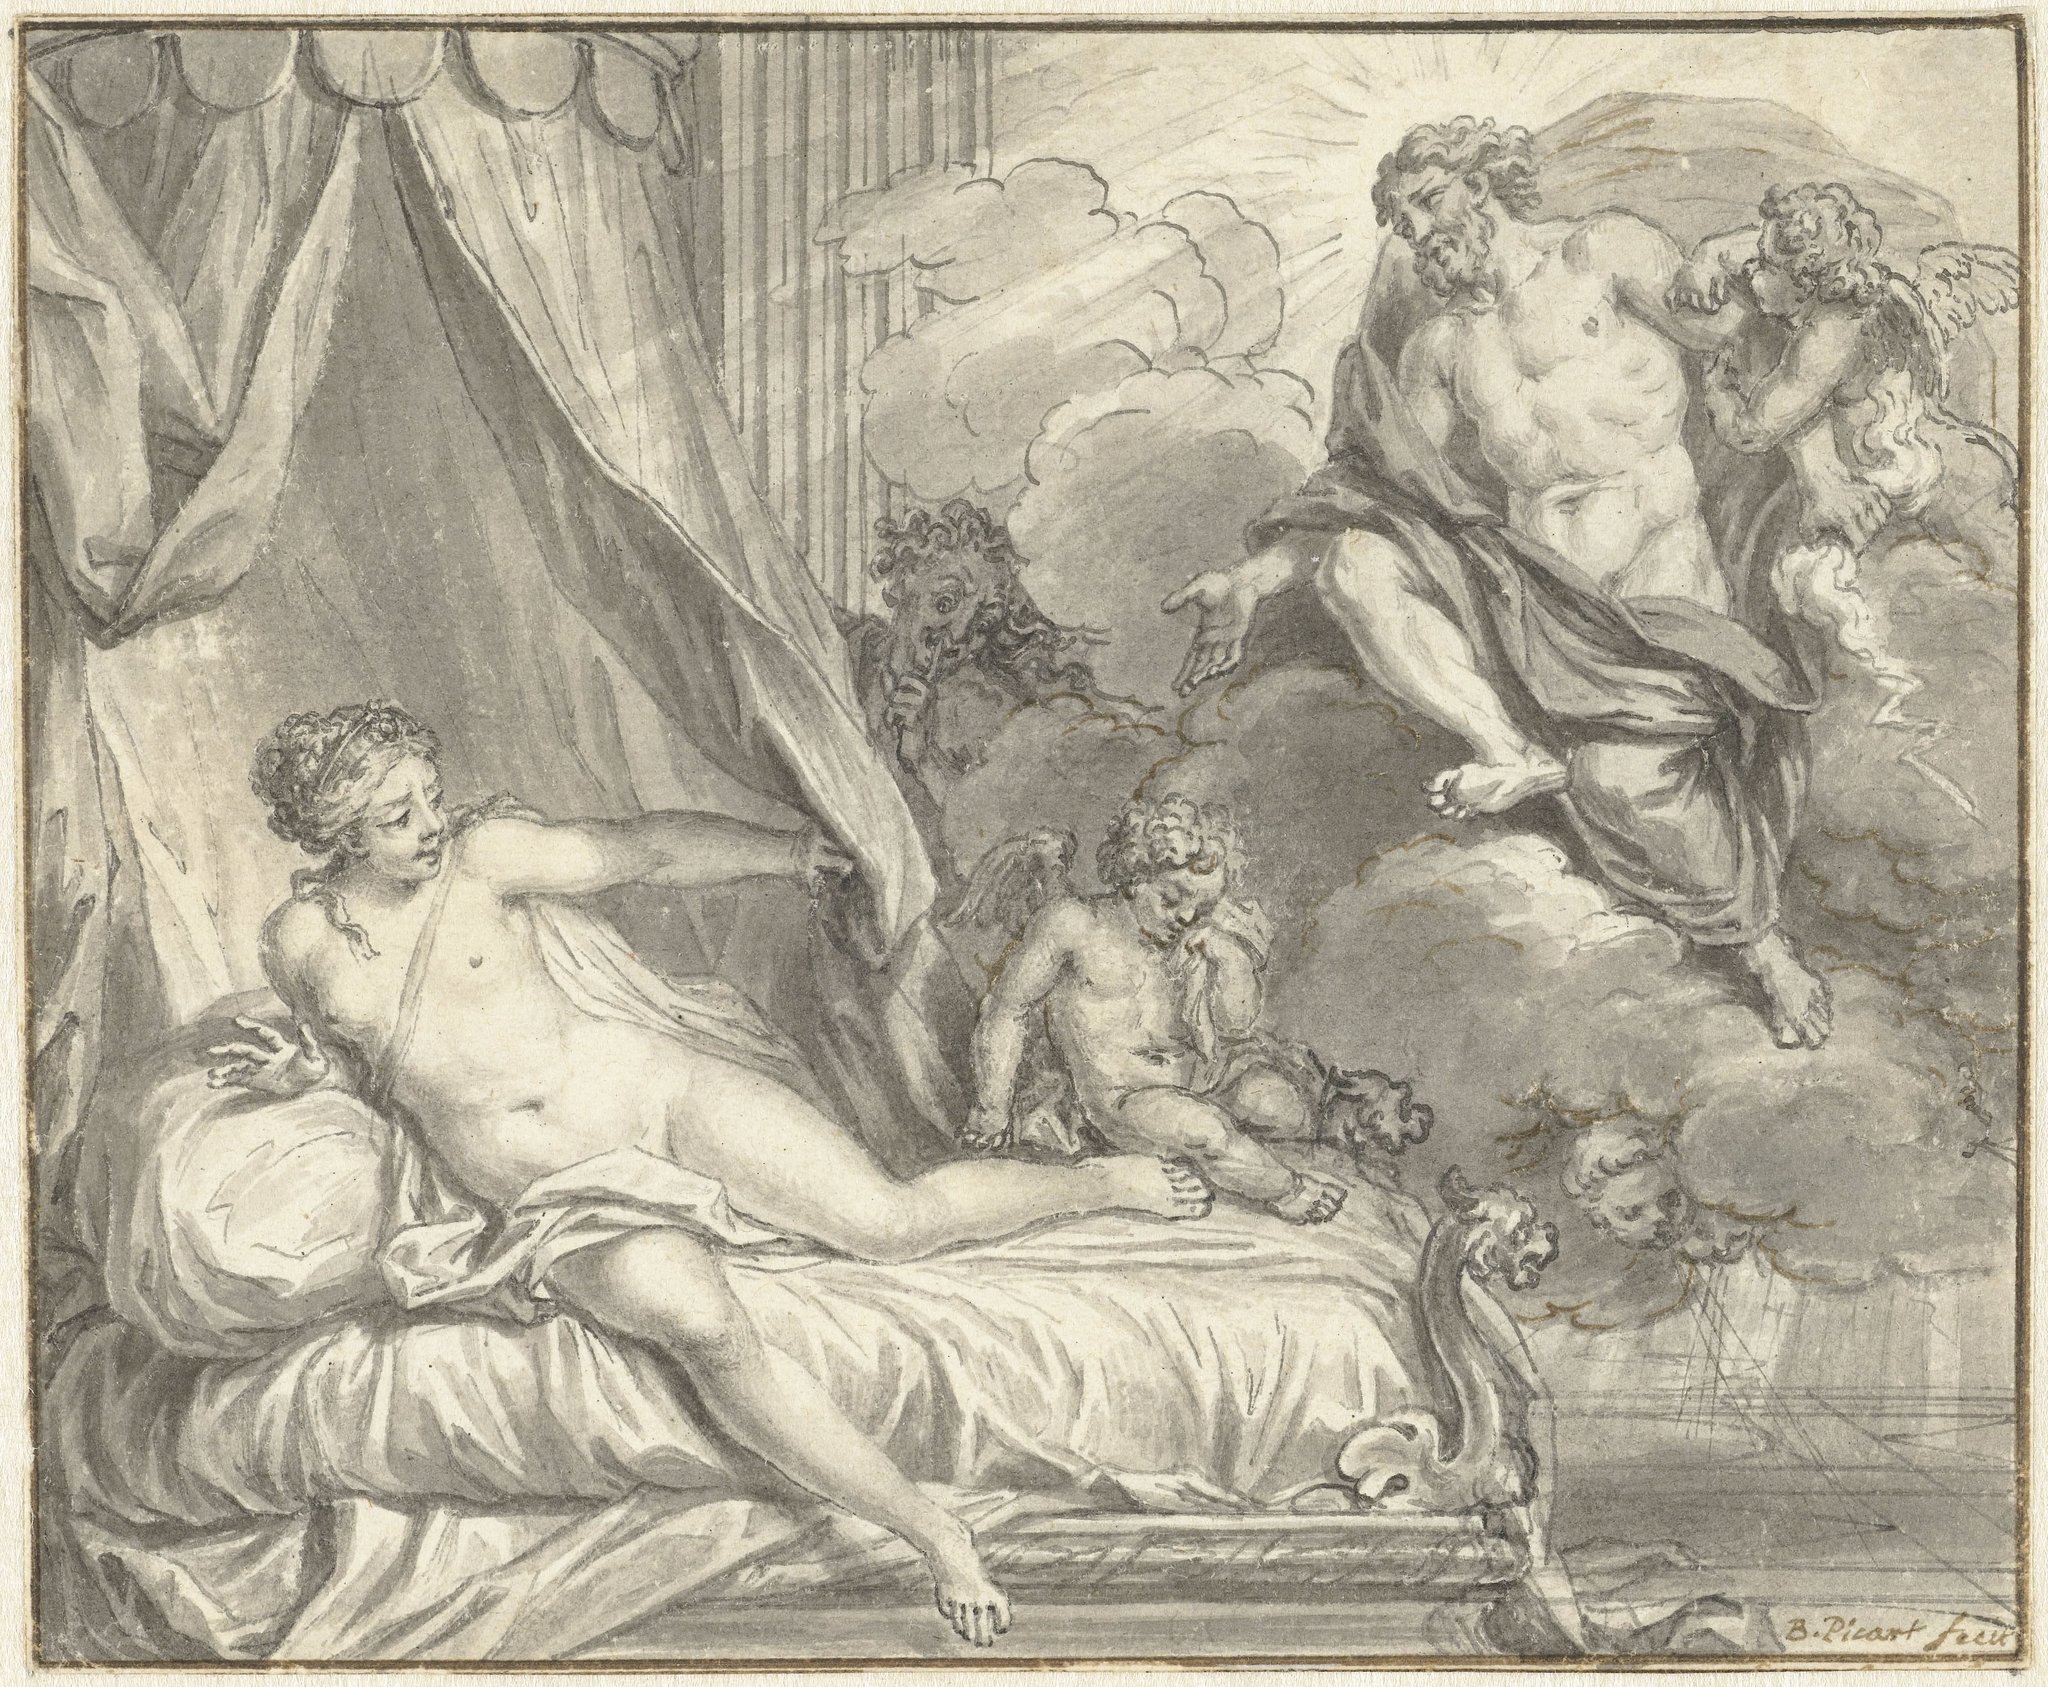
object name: design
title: Jupiter en Semele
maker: bernard picart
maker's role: draughtsman, print maker, publisher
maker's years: 1673-1733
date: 1683-1733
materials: ink, paper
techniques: brush, pen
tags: jupiter kills semele by coming to her with his lightning and thunderbolts